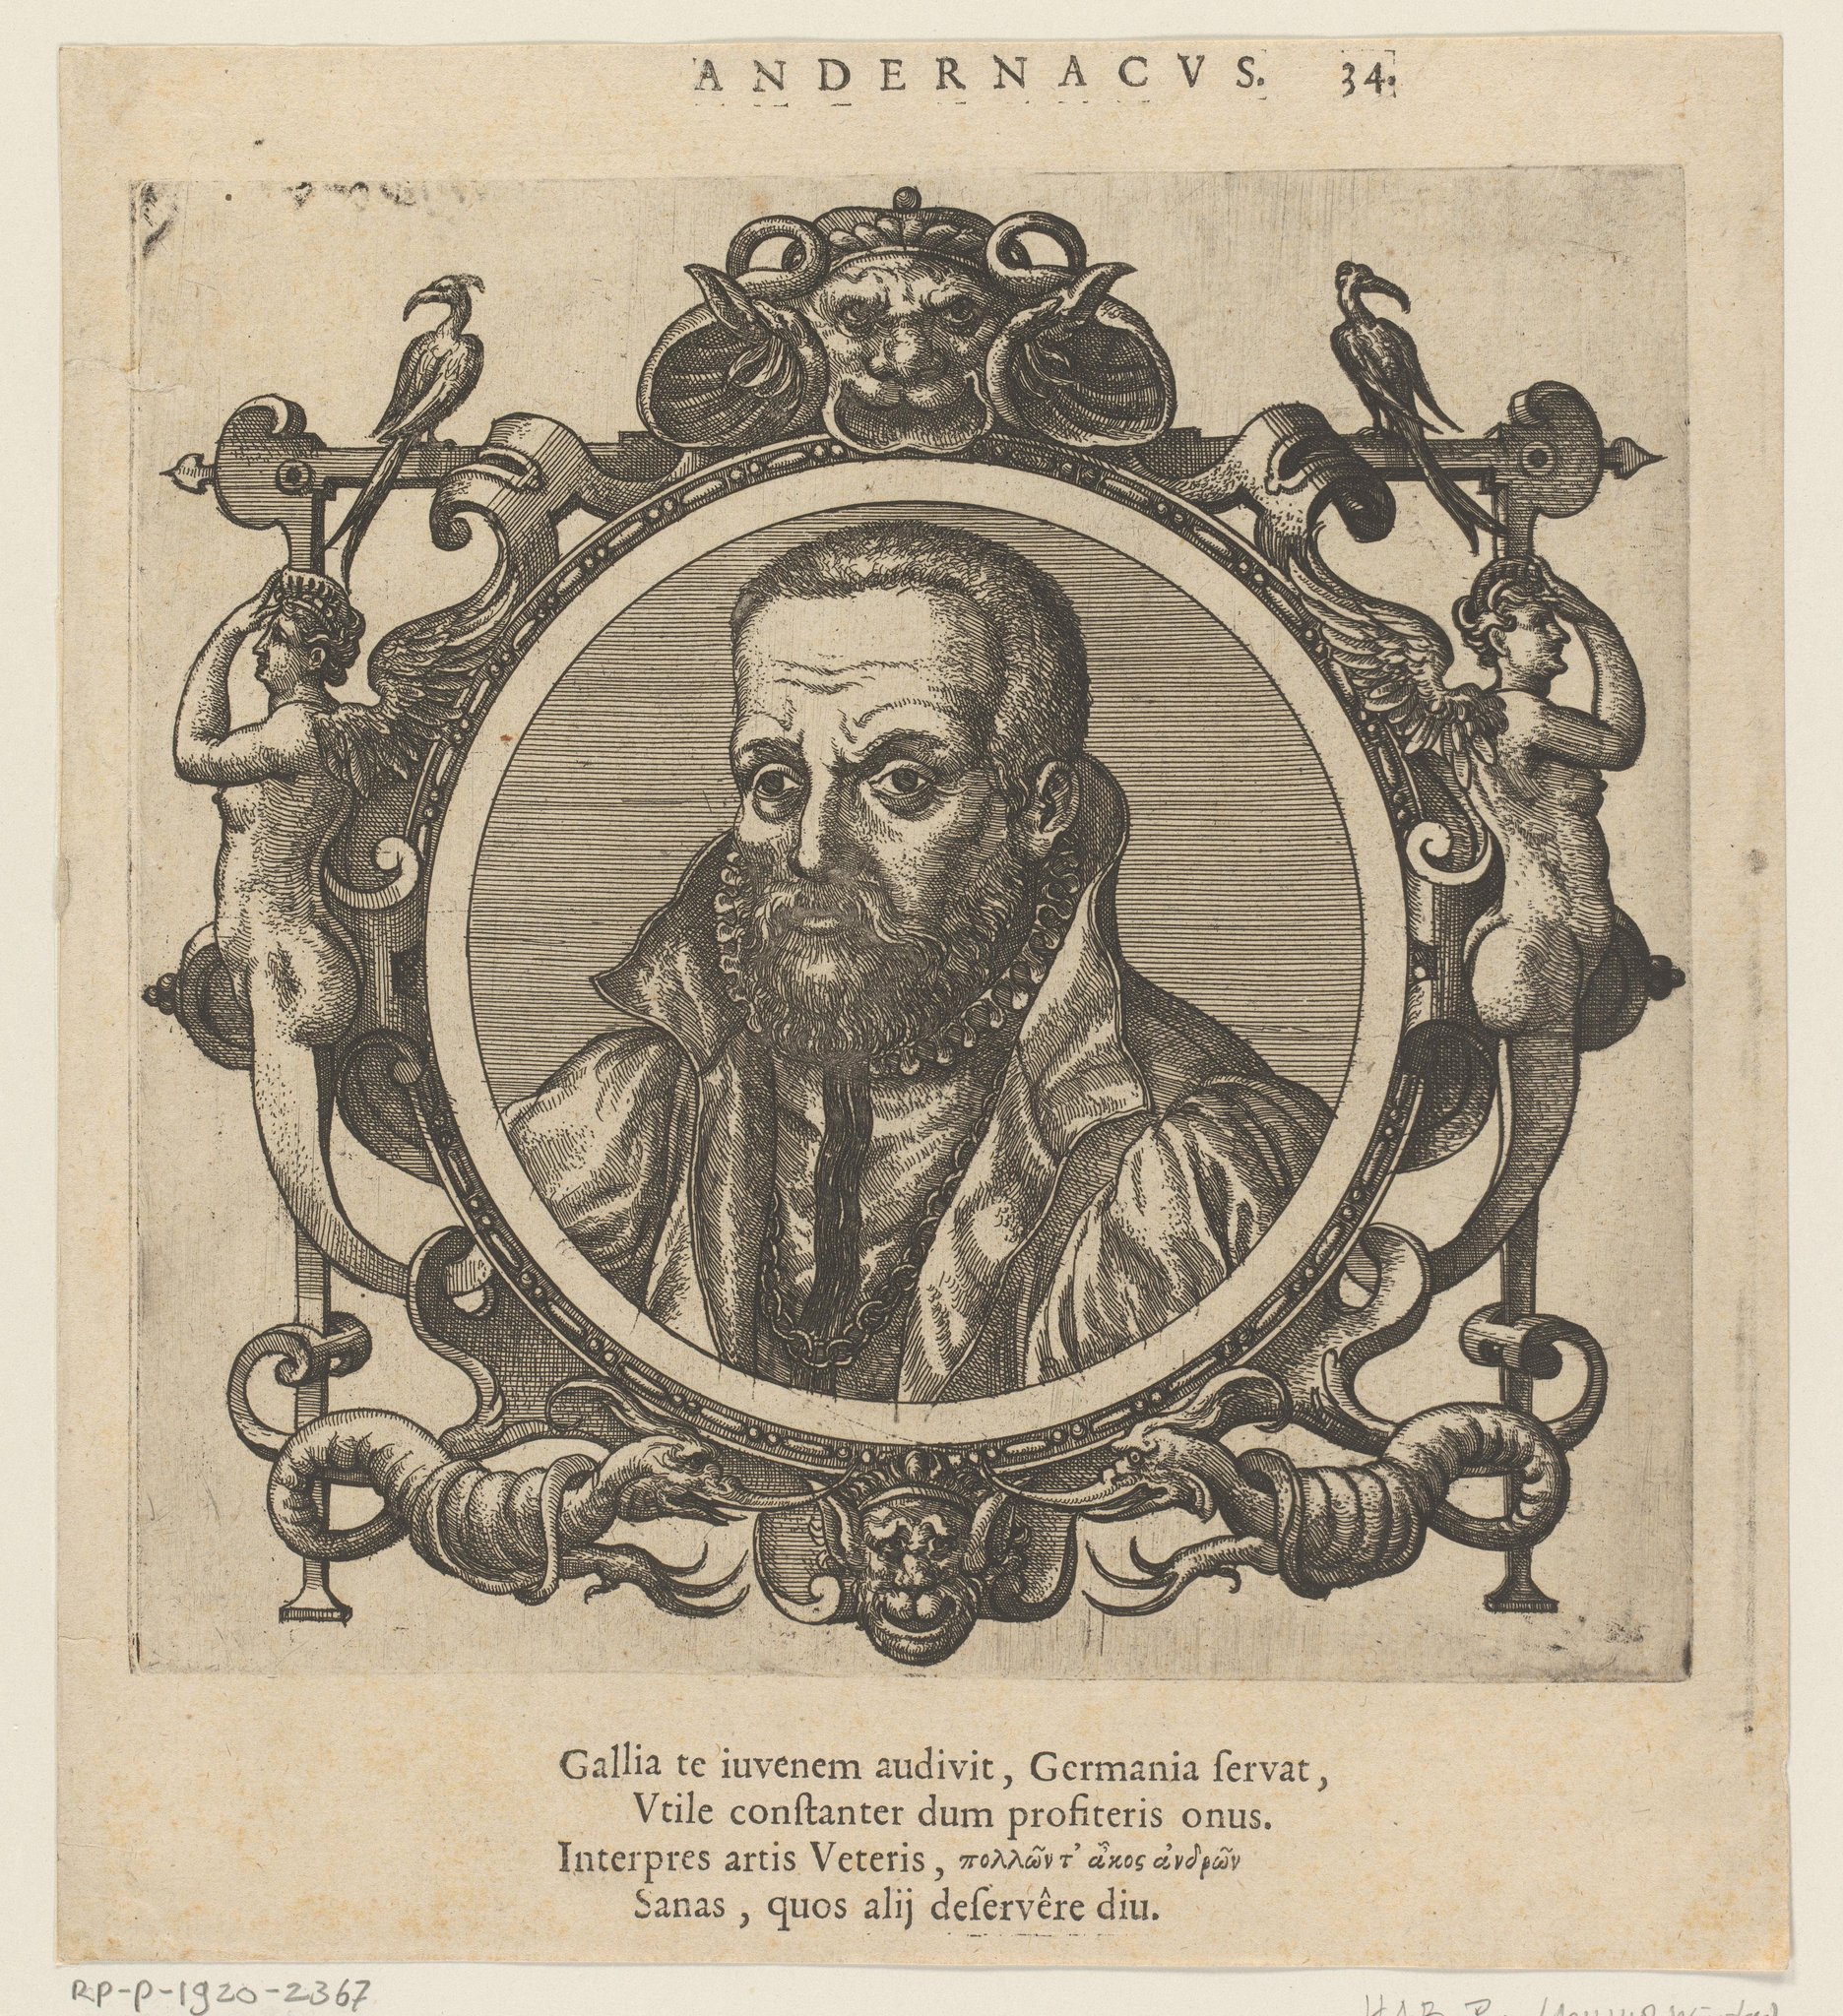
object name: print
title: Portretten van filosofen en medici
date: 1574-1612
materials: paper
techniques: etching, letterpress printing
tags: scrollwork, strapwork ~ ornament, scholar, philosopher, historical persons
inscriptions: collector's mark: Lugt 2228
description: Portretbuste in ronde ornamentale omlijsting.